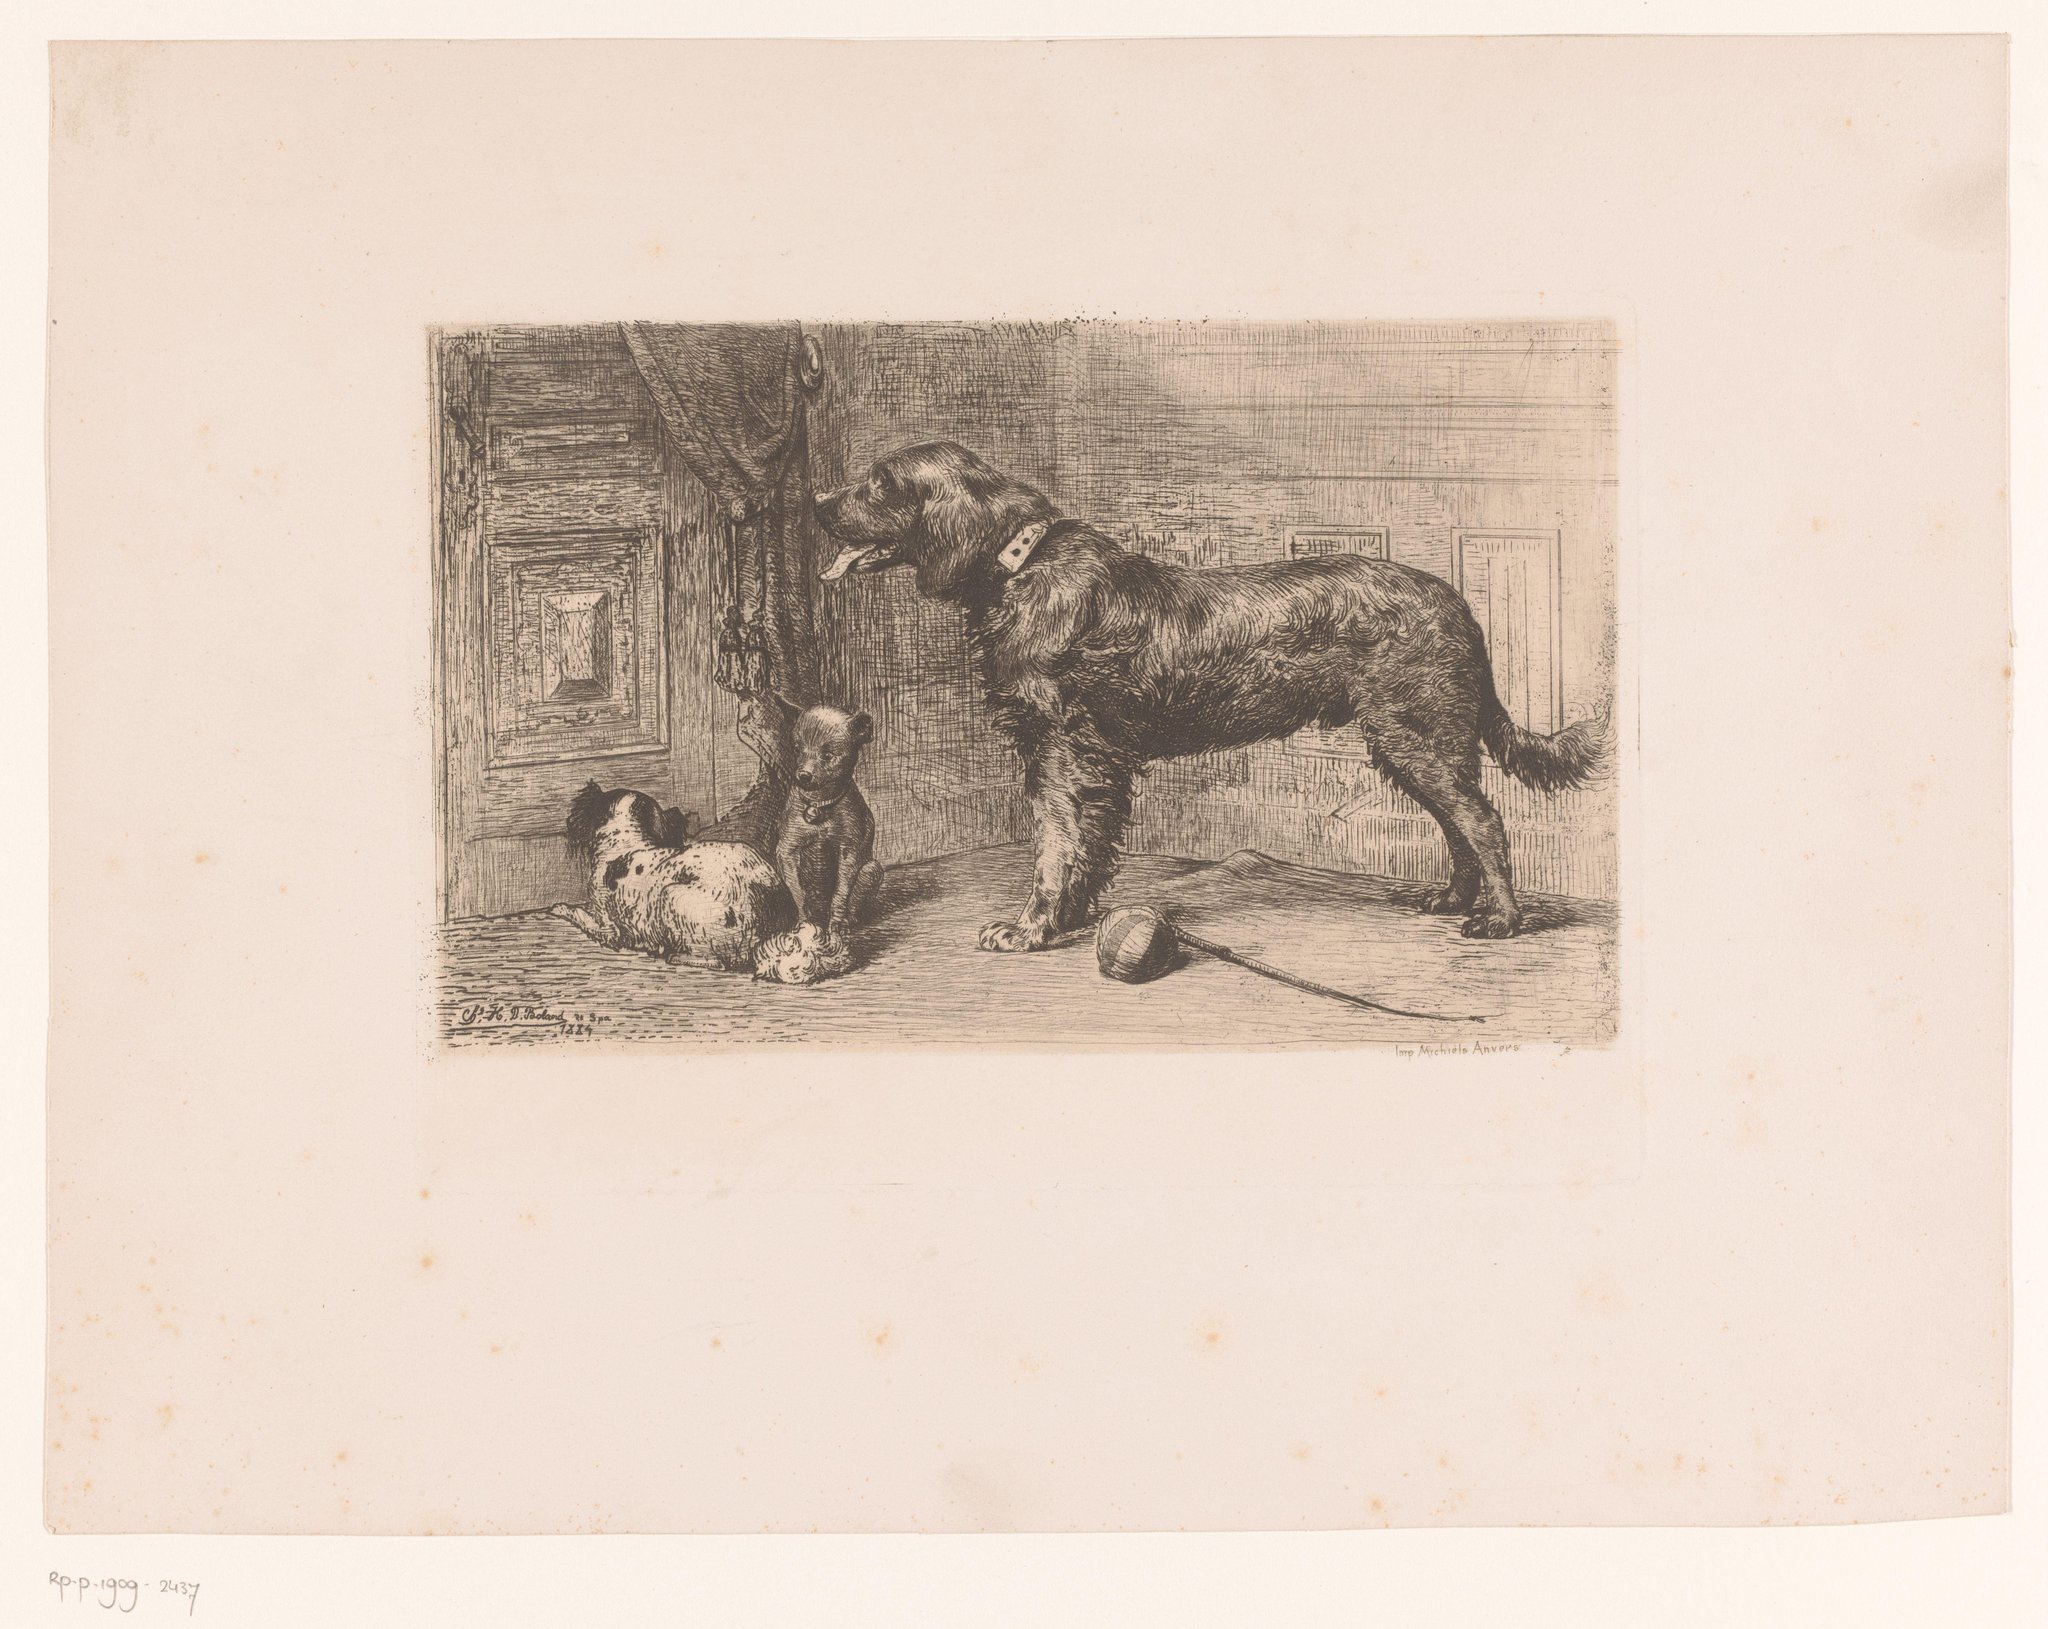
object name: print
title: Drie honden wachten bij een deur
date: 1884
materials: paper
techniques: drypoint, etching, intaglio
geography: antwerp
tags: dog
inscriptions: collector's mark: Lugt 2228